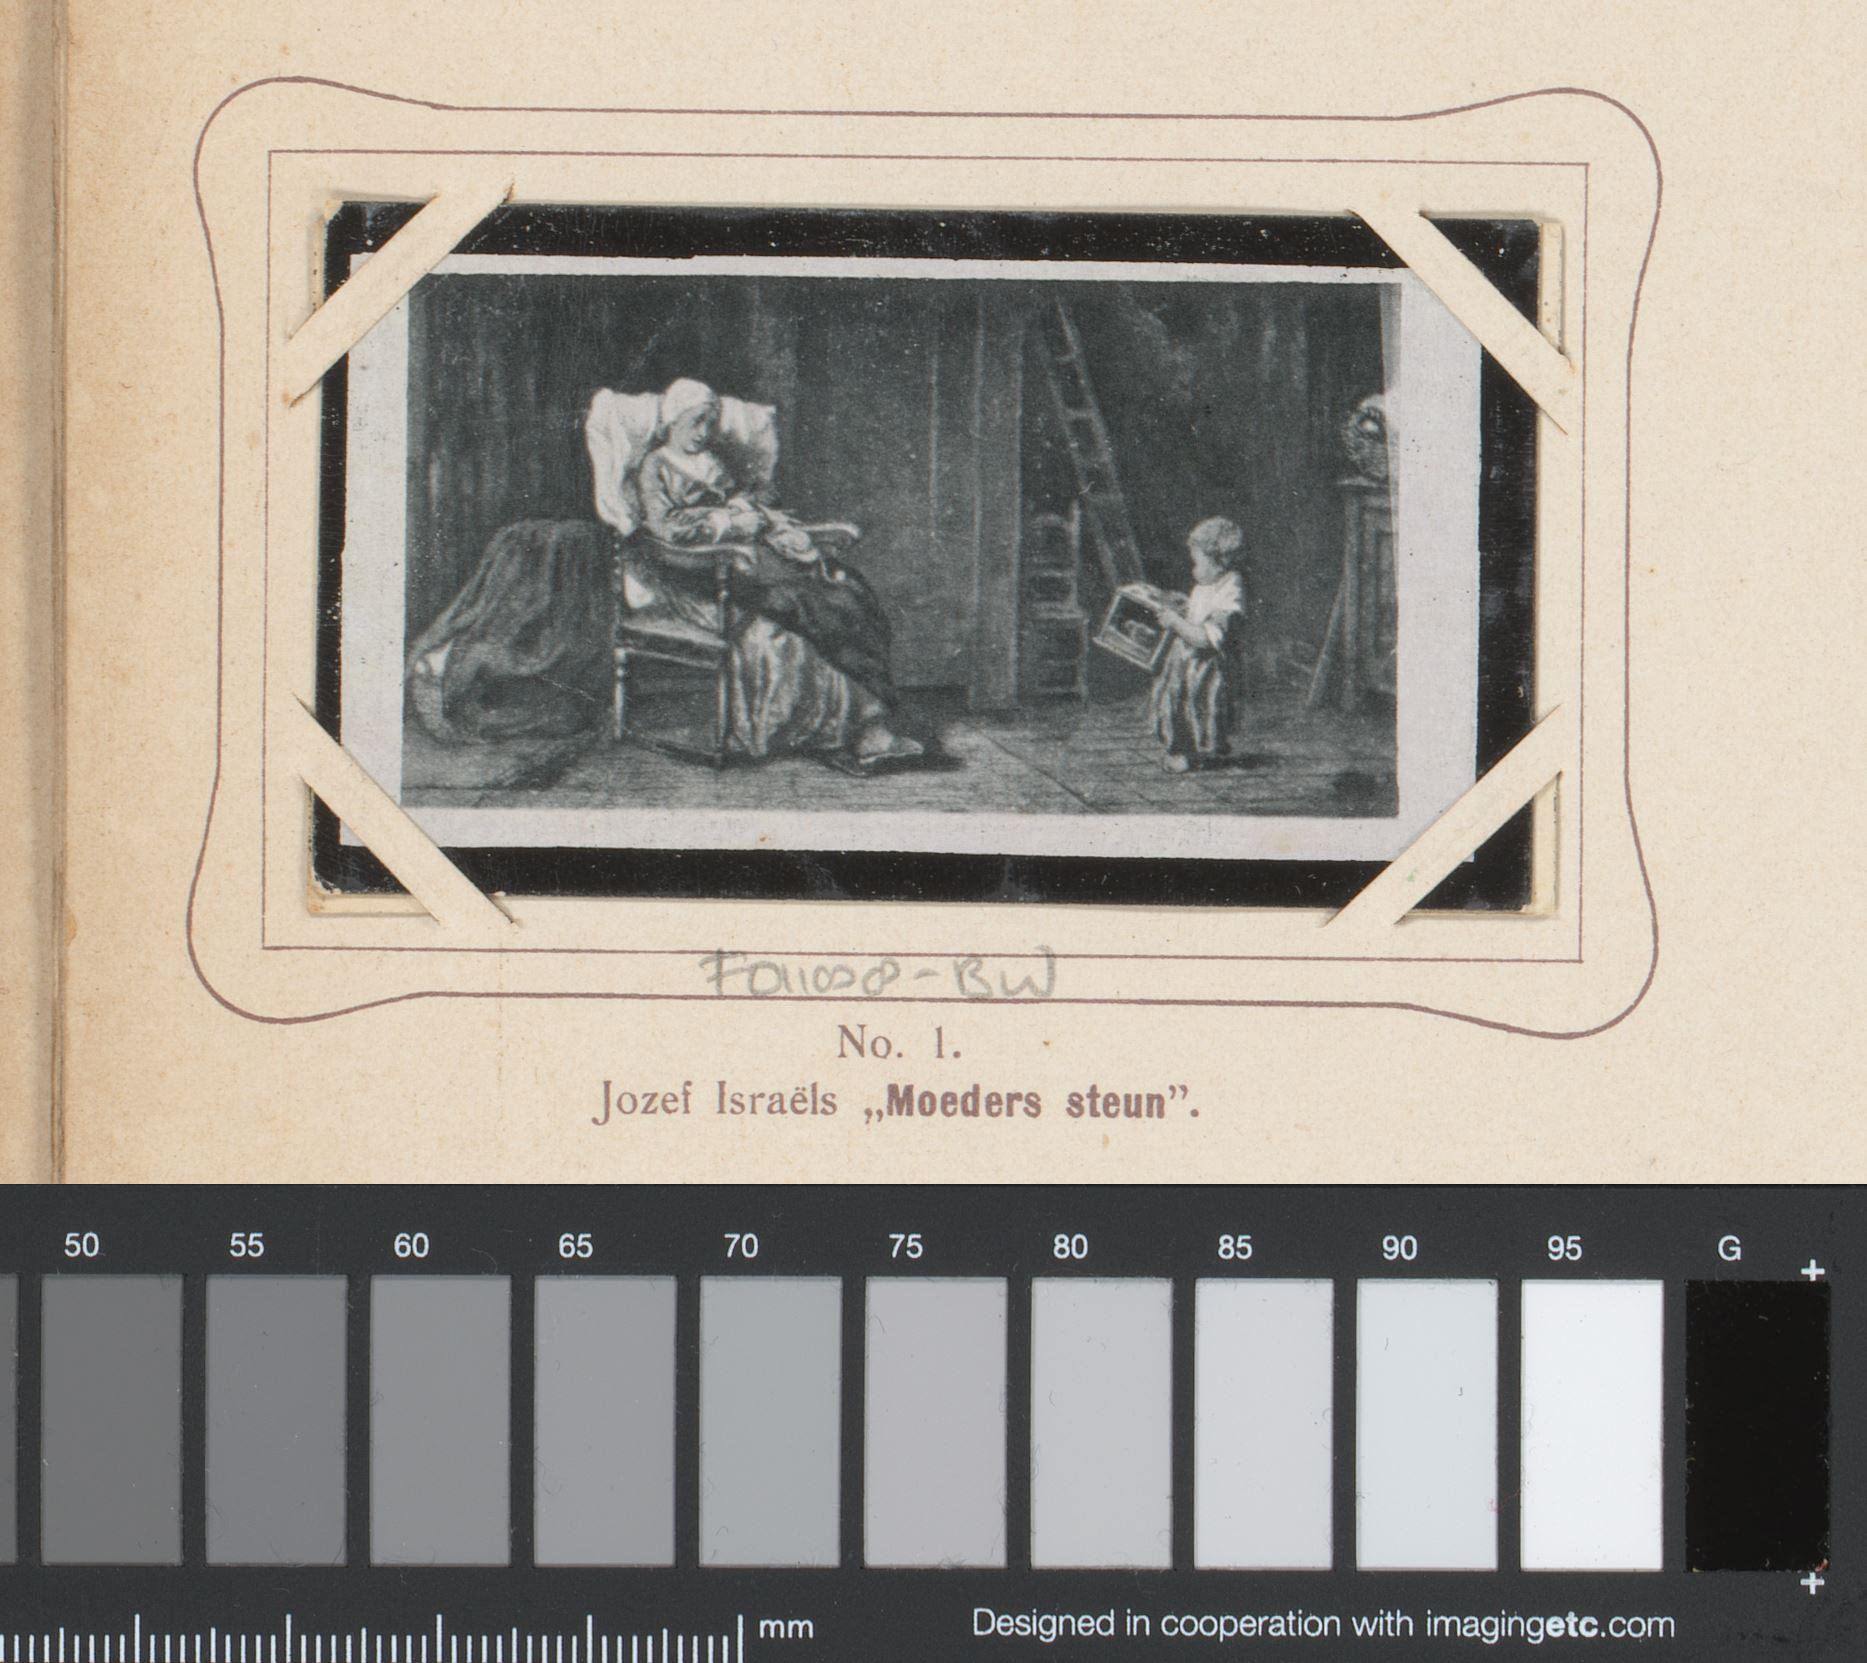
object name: reproduction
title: Reproductie van een schilderij van een zittende moeder en een kind met een voetensteun naar Jozef Israëls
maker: Anonymous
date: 1906-1907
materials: paper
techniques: photograph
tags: footstool, sitting figure - aa - female human figure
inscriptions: inscription: ‘No. 1./ Jozef Israëls "Moeders steun".’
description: Deze prent maakt deel uit van een album.